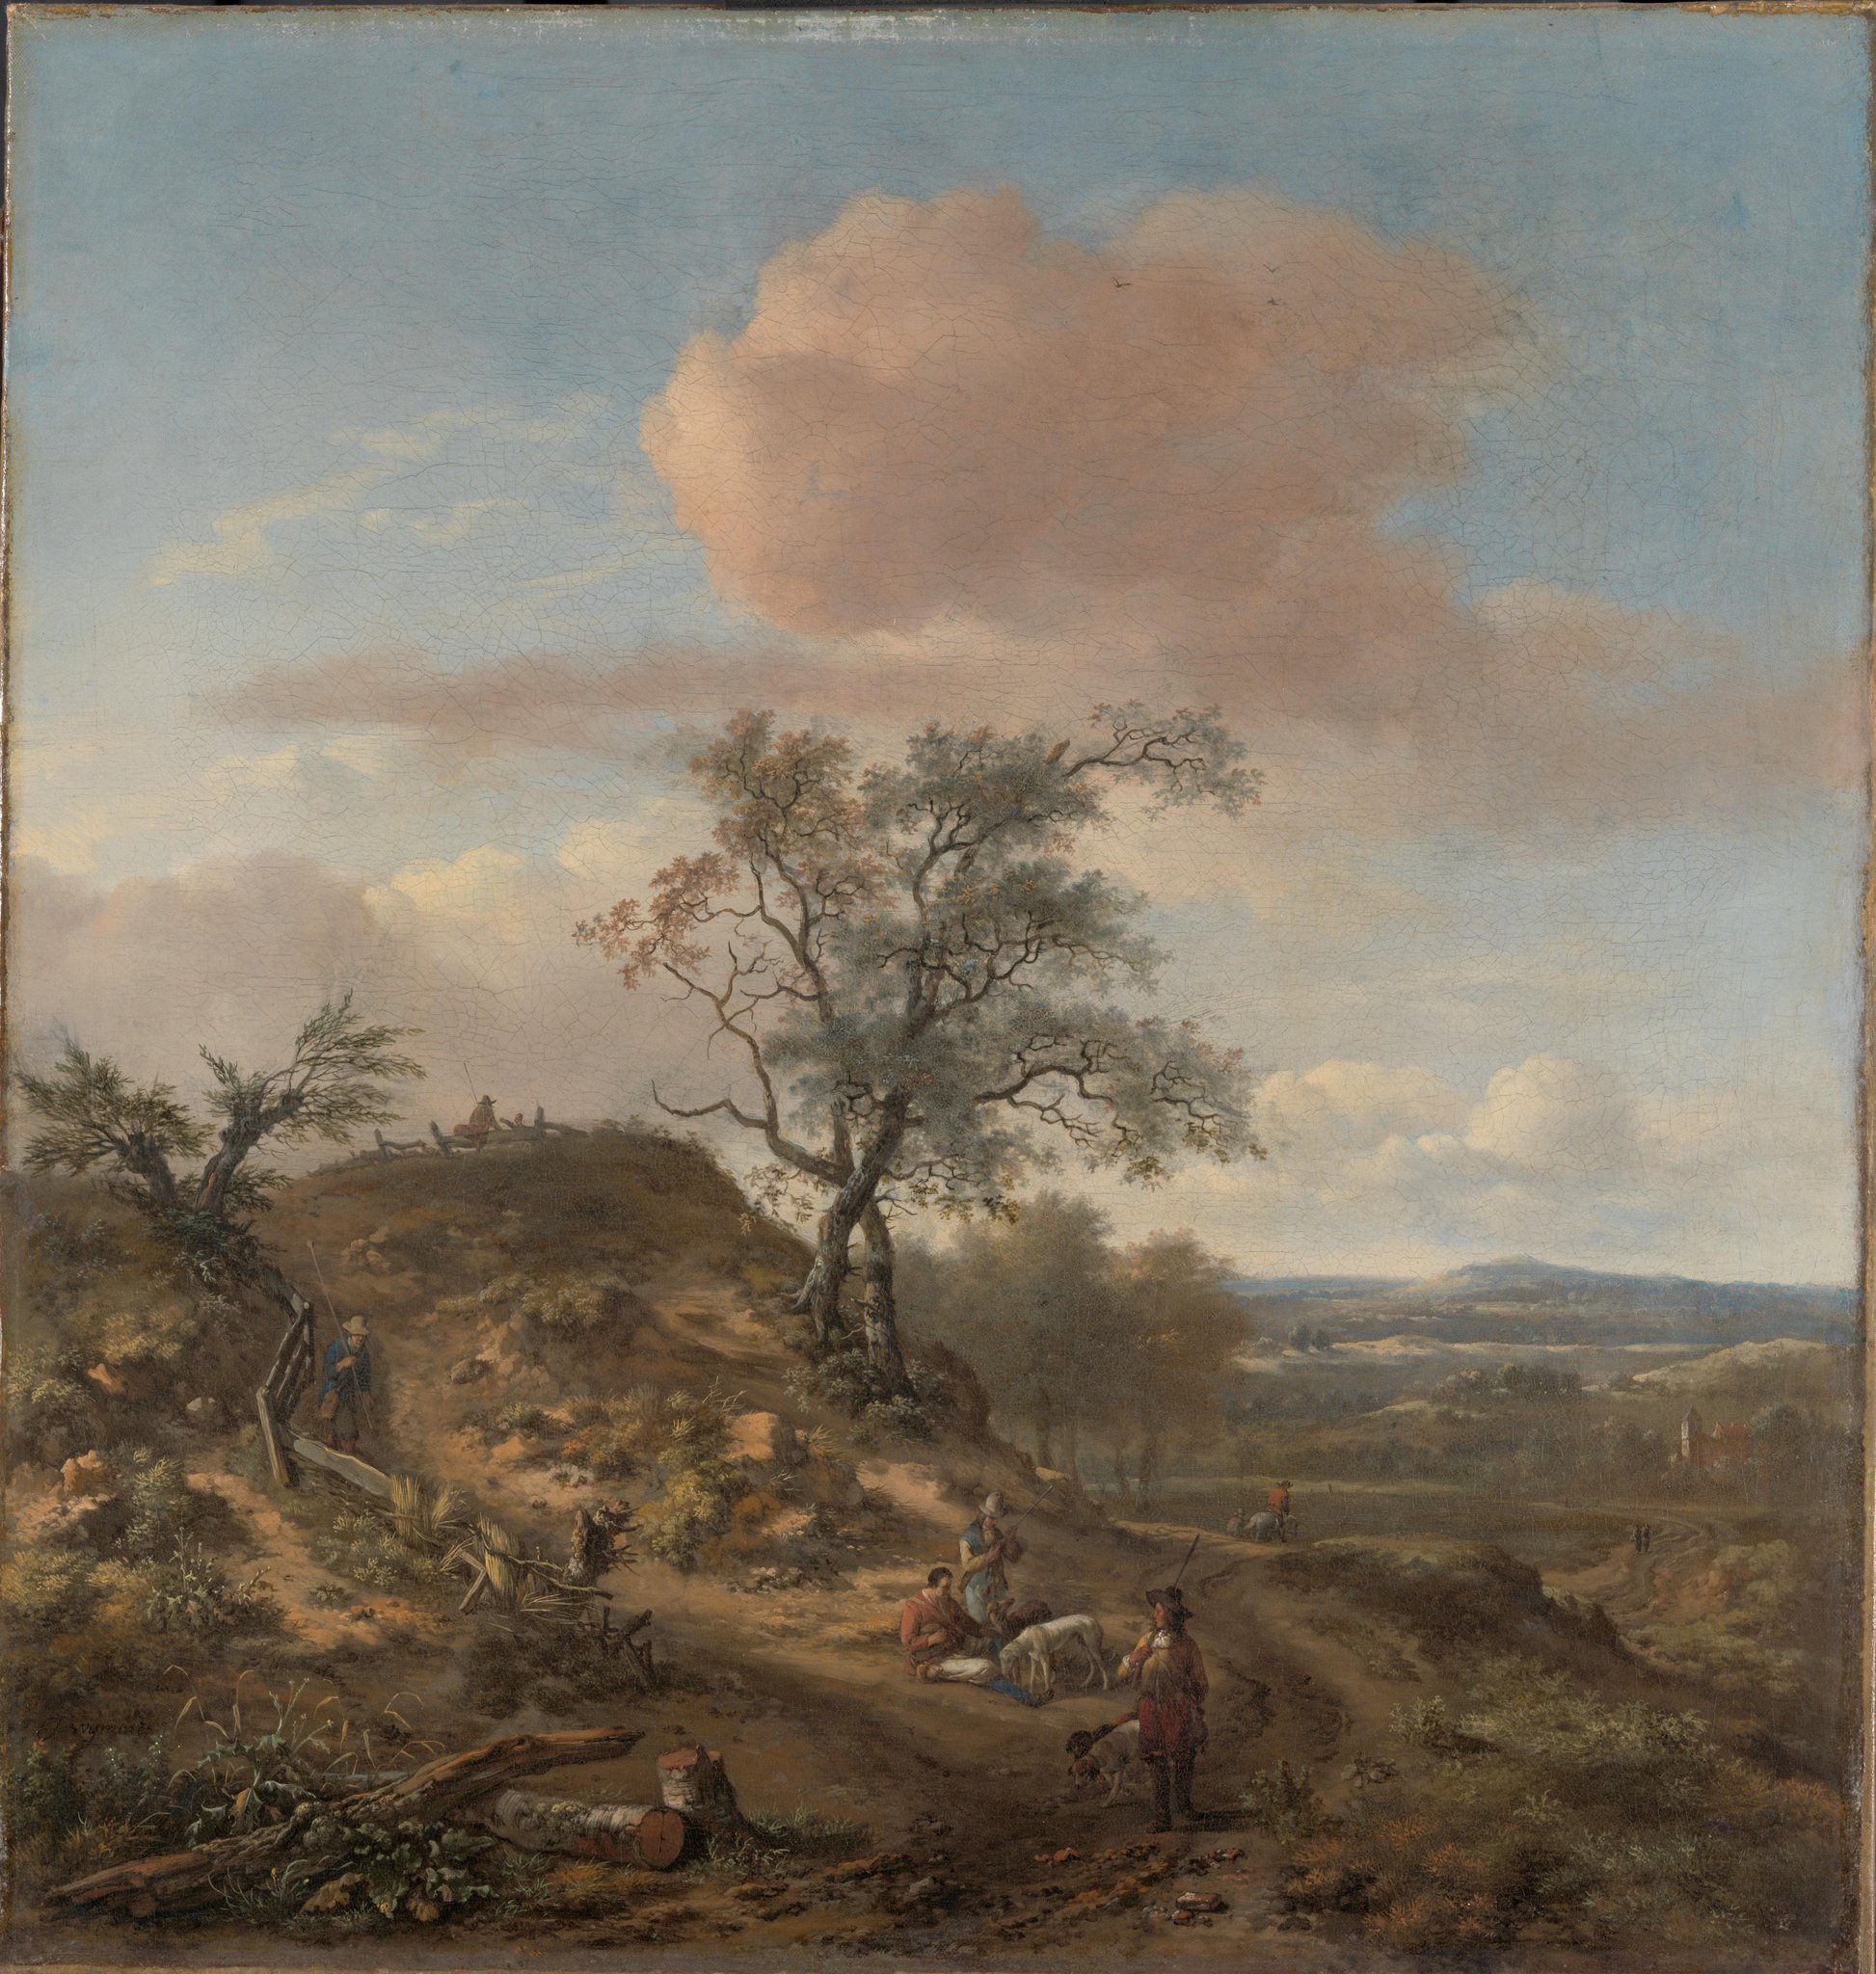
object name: painting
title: Landscape with a Hunter and other Figures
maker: jan wijnants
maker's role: draughtsman, painter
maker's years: 1632-1684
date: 1660-1670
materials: canvas, oil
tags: low hill country, hunter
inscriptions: signature: ‘J.Wijnants’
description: Jan Wijnants (1631/32 - 1684). Landscape with a hunter and other figures, c. 1670. A half-dead tree dominates this work, a motif which the artist borrowed from Jacob van Ruisdael. Jan Wijnants produced a great many paintings, not all of them of equally high quality. From 1660 on he lived in Amsterdam, where Philips Wouwerman was one of the most sought-after landscape artists of his day. Jan Wijnants undoubtedly studied the work of his successful fellow Amsterdammer. Bequest of A. van der Hoop, 1854. On loan from the city of Amsterdam, 1885.